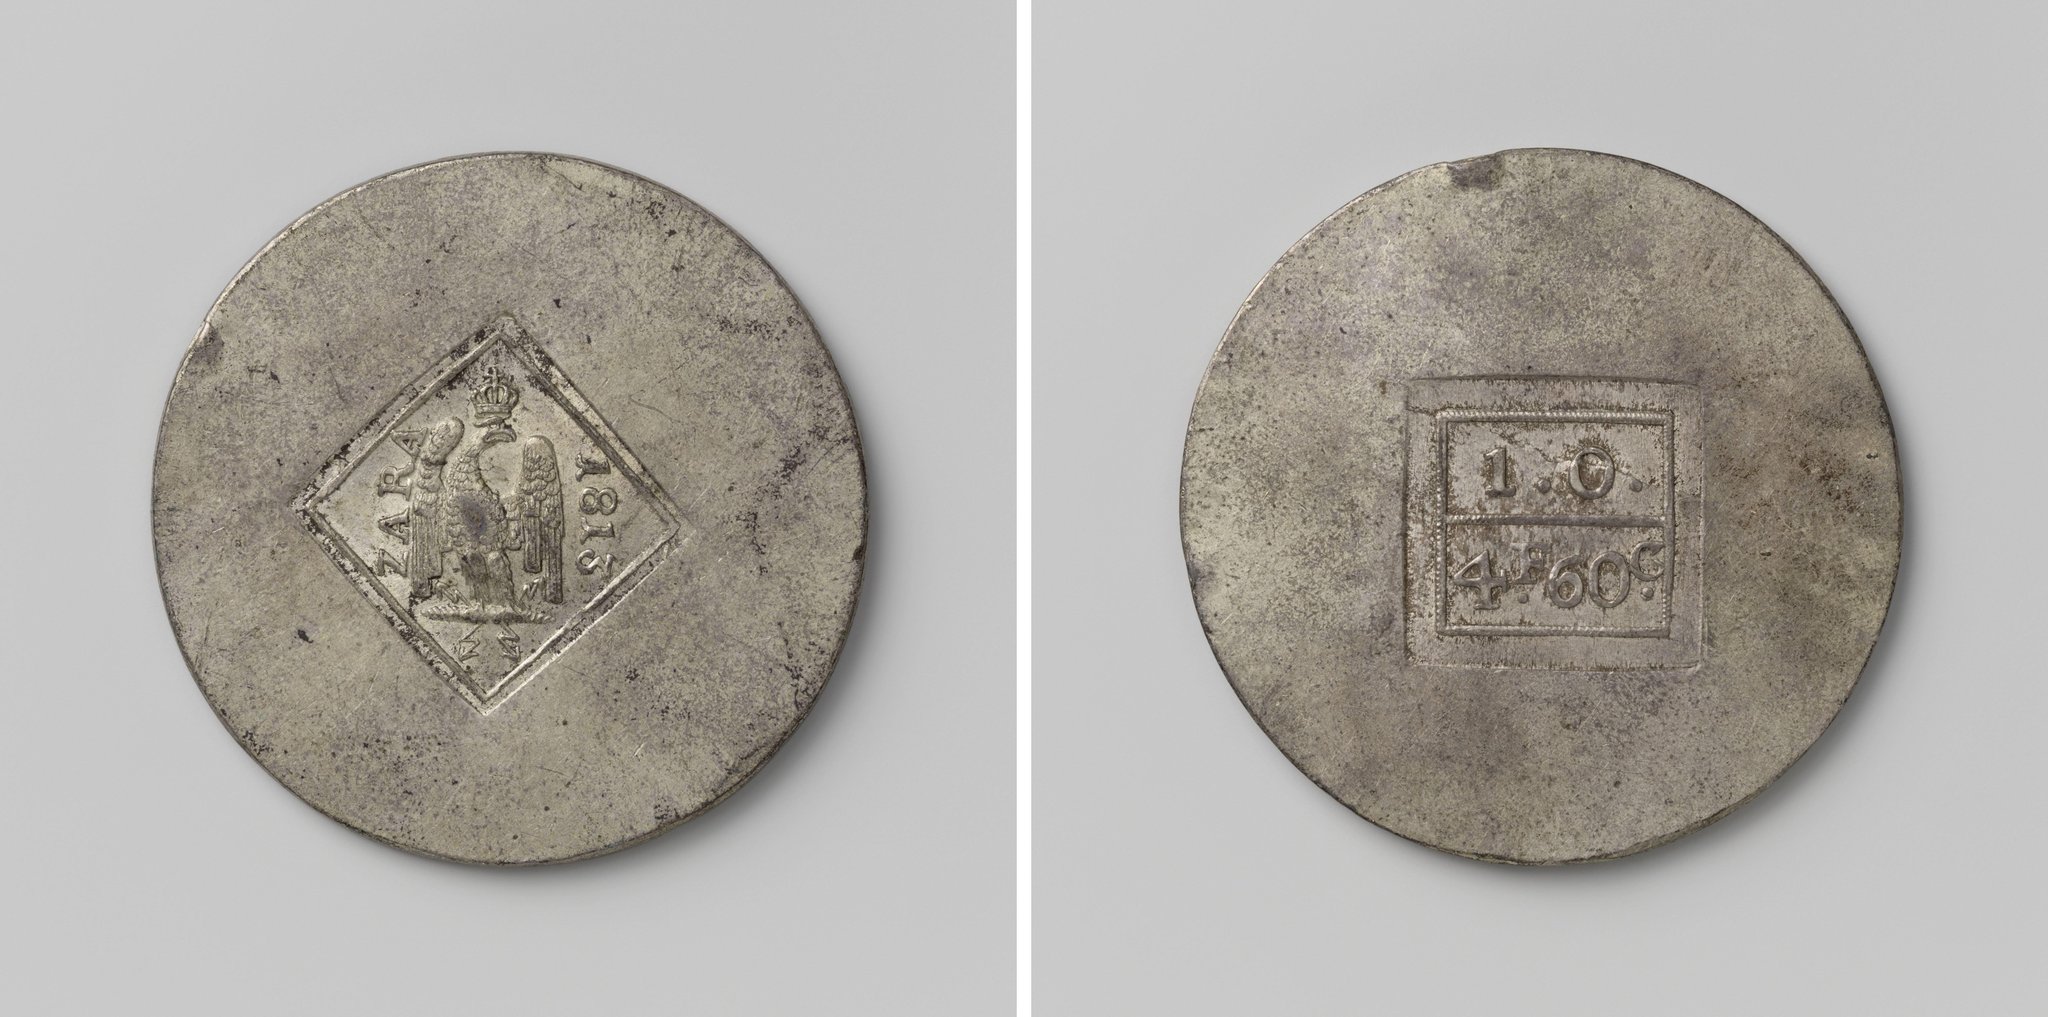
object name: siege coin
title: Vier francs zestig centimes, noodmunt uit Zara, geslagen tijdens het beleg door de Oostenrijkers, door de Fransen op een gewicht van een ons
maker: Anonymous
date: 1813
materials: silver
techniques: striking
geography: zara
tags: zara, beleg van zara